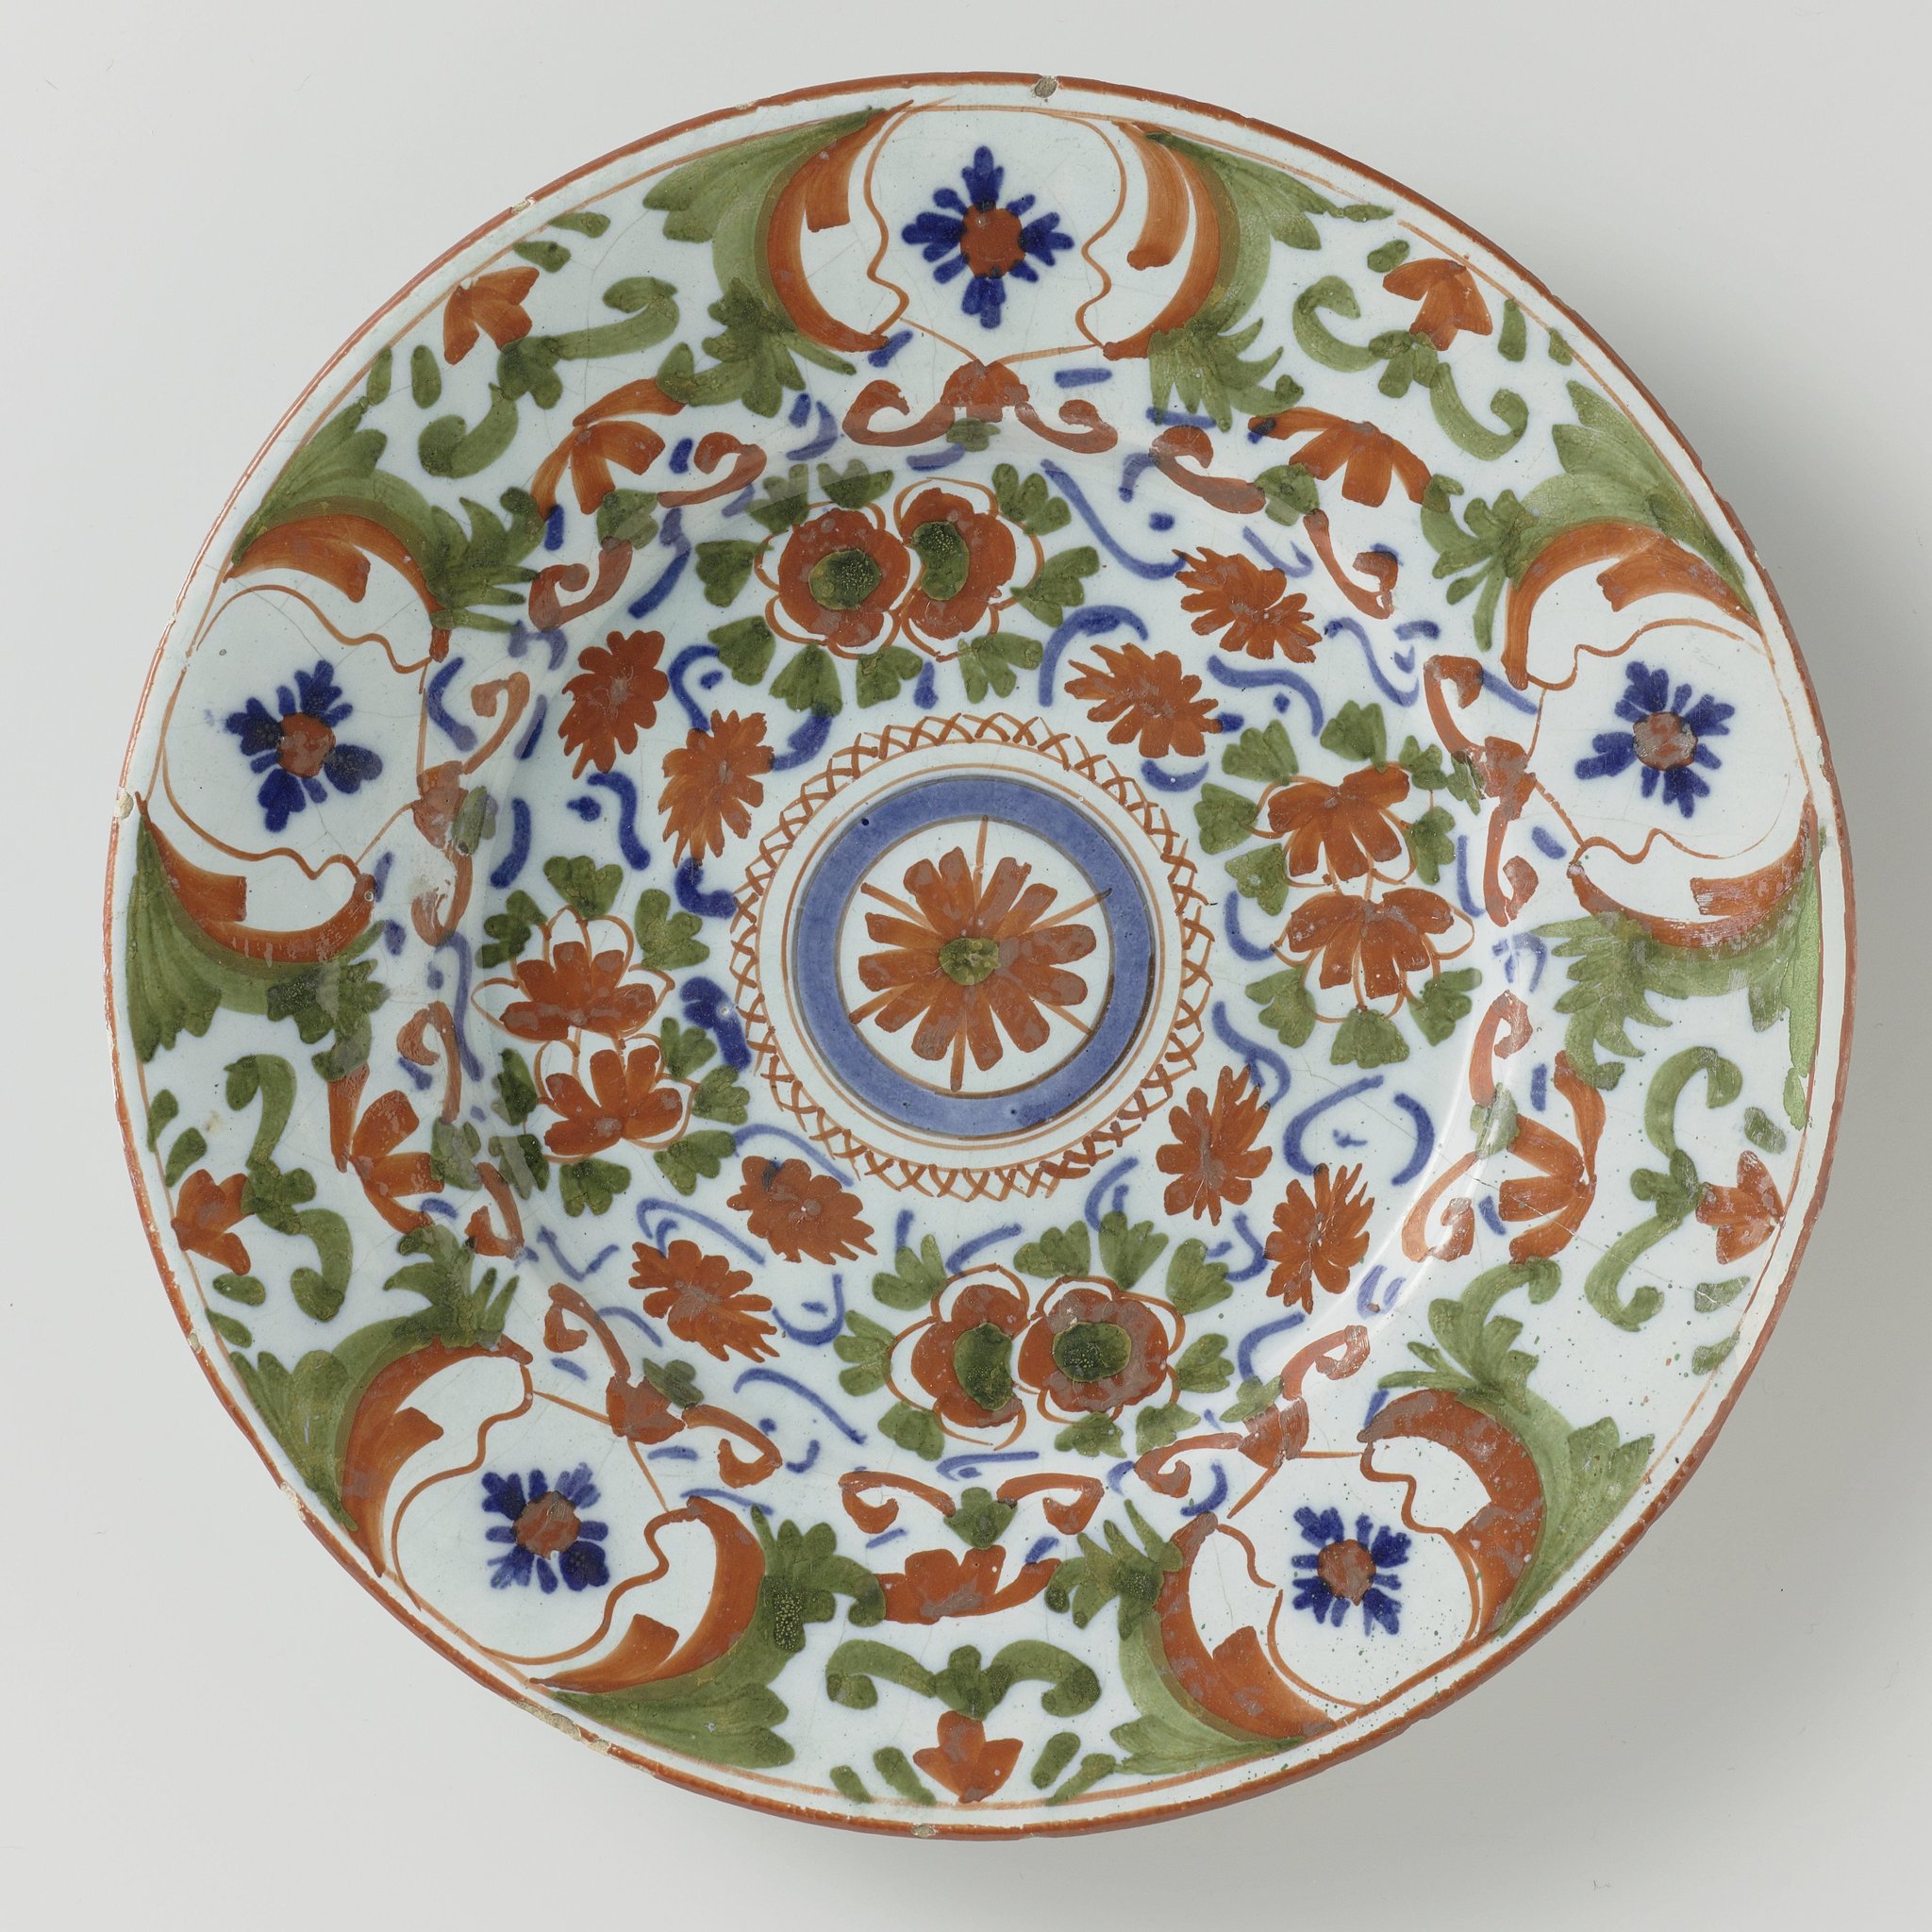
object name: plate dish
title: Bord van veelkleurig beschilderde faience met bloemdecoratie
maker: Anonymous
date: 1740-1780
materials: earthenware, glaze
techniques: painted, polychromy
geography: delft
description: Rond bord van veelkleurig beschilderde faience, beschilderd met bloemen en bloemmotieven in de kleuren groen, rood en blauw. Bij het bord horen drie identieke borden met invnrs. BK-NM-13351-a,BK-NM-13351-b en BK-NM-13351-c.